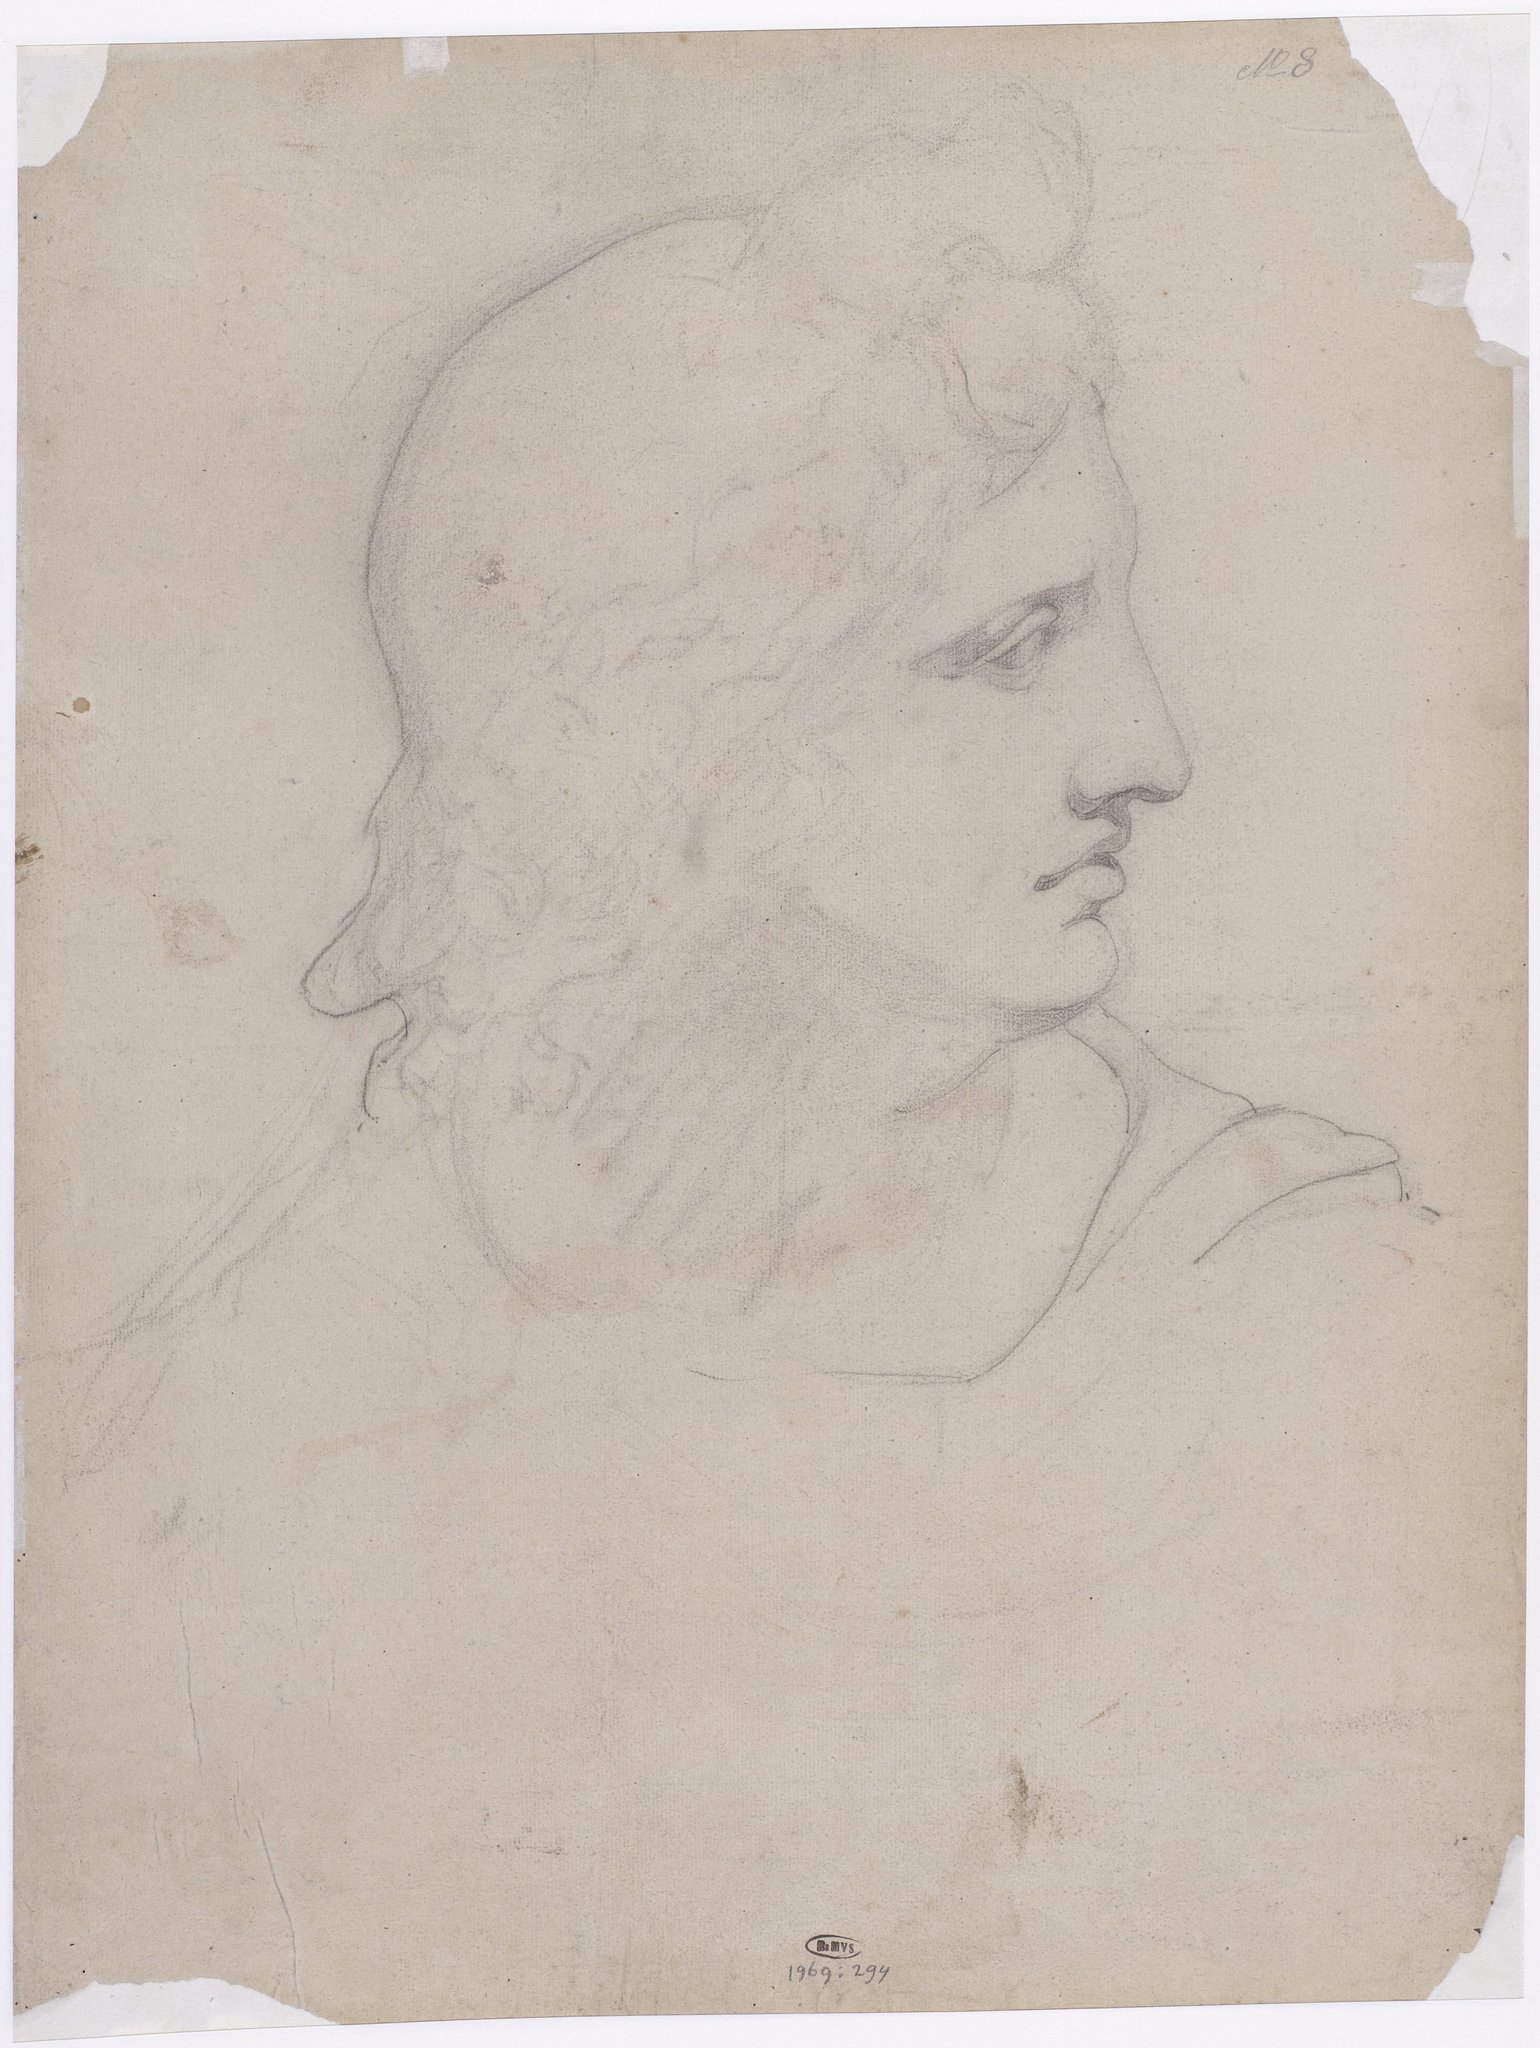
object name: drawing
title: Academiestudie naar Romeinse kop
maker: gerrit willem dijsselhof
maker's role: designer, draughtsman, print maker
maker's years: 1866-1924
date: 1876-1924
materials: charcoal, paper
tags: head (human), piece of sculpture, reproduction of a piece of sculpture